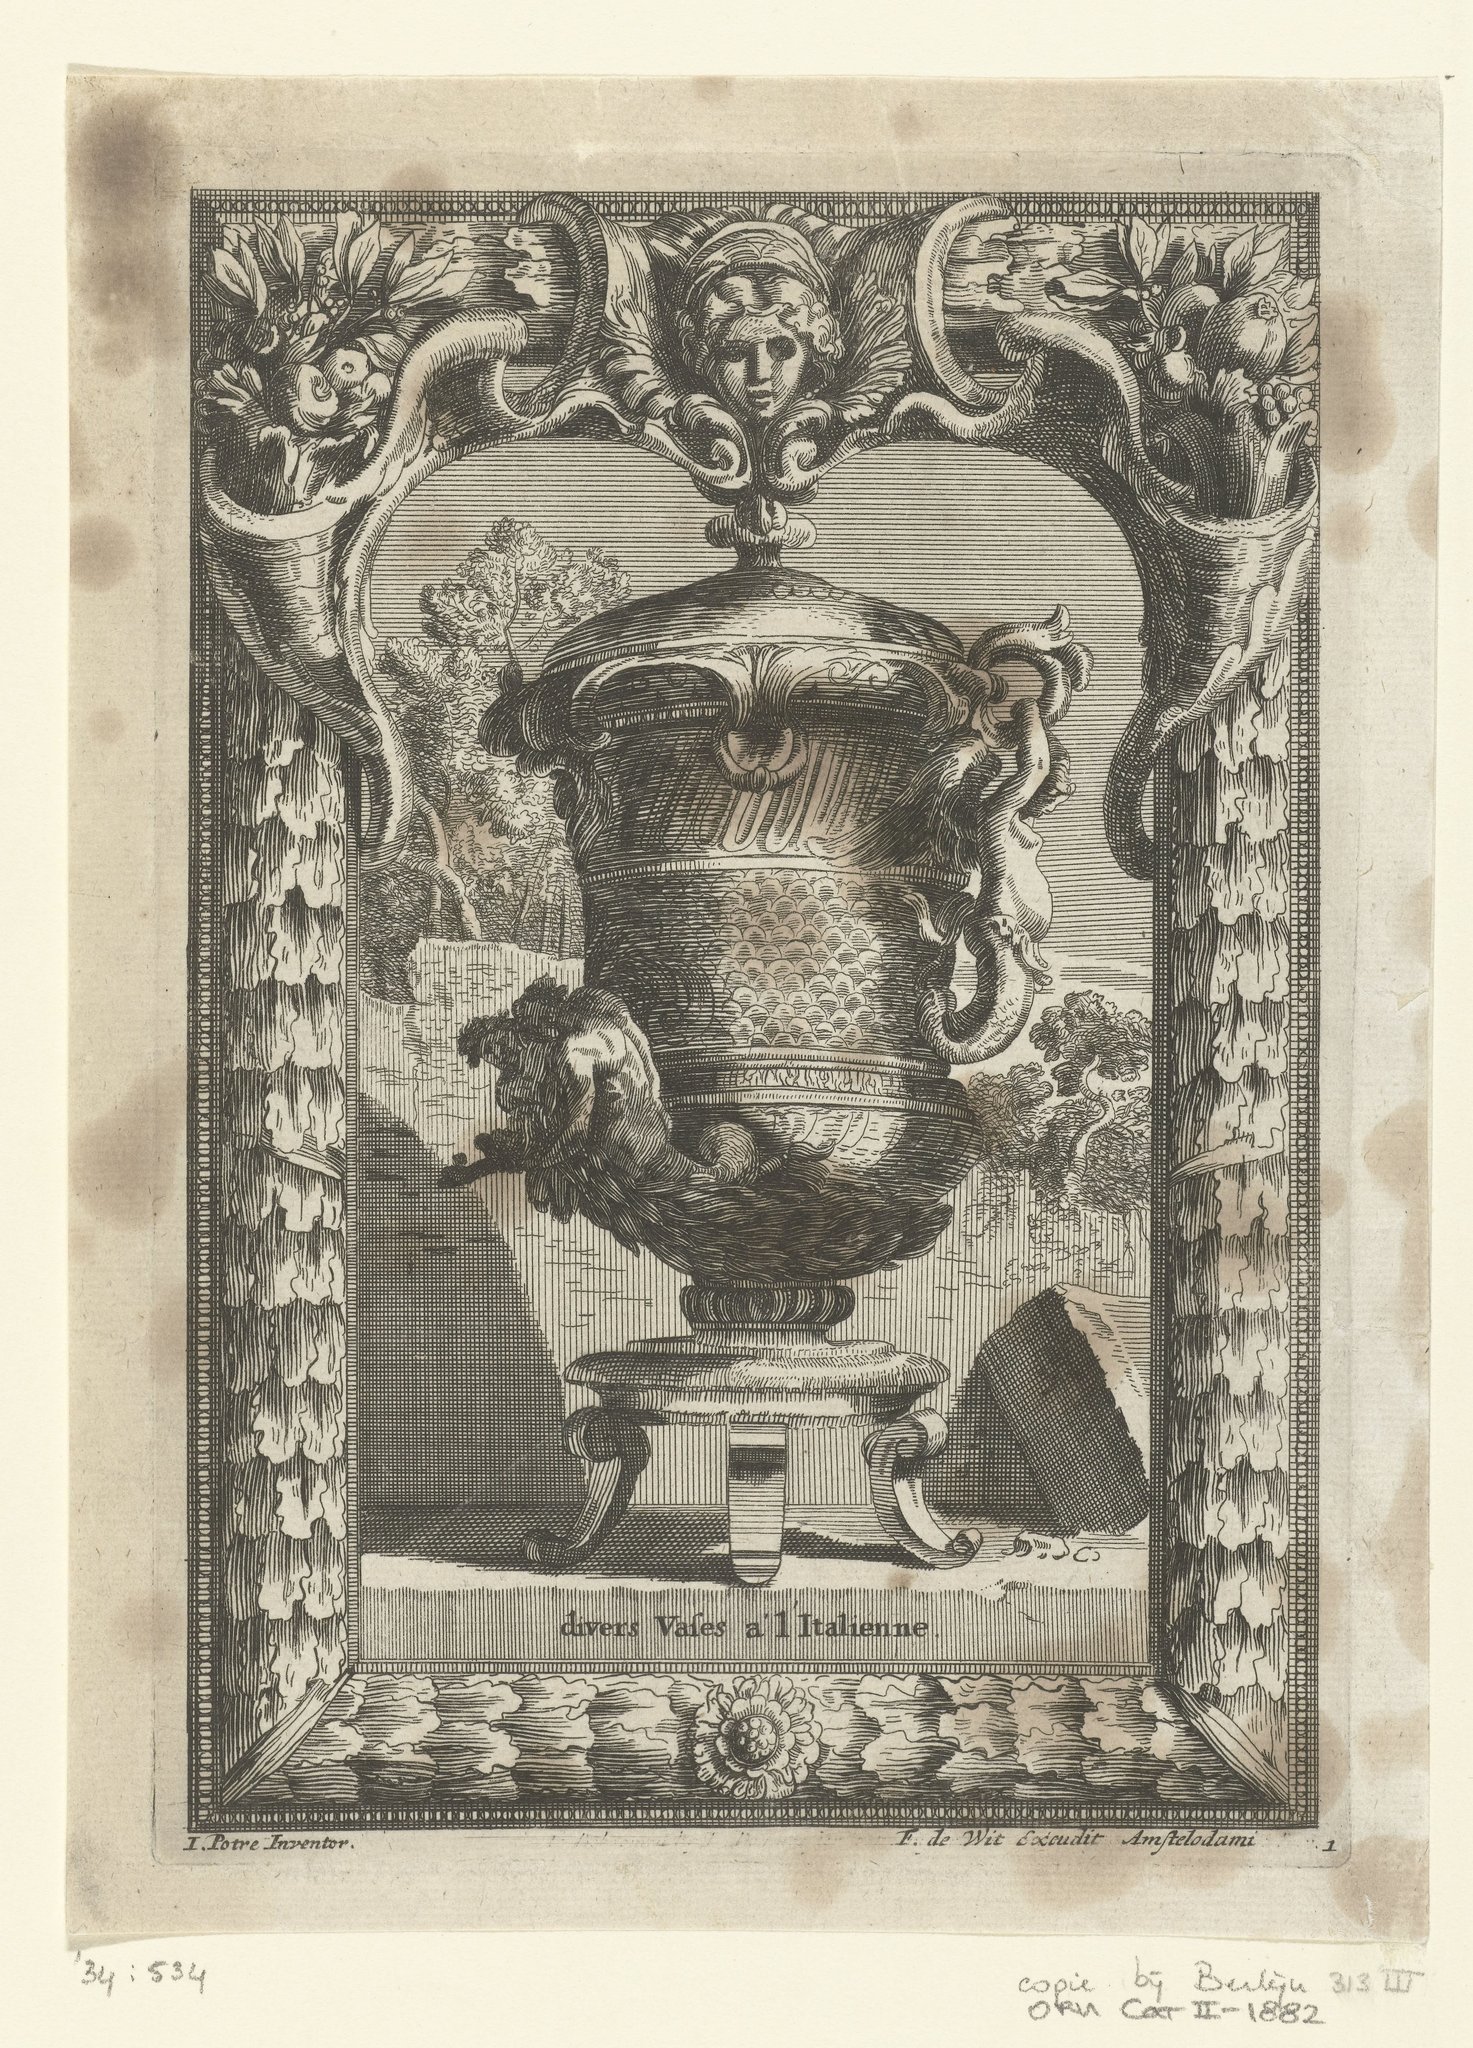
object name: print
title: Diverses Vases à l'Italienne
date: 1655-1678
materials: paper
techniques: etching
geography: amsterdam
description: Mobiele waterfontein op een driepoot, onderaan staat de titel.